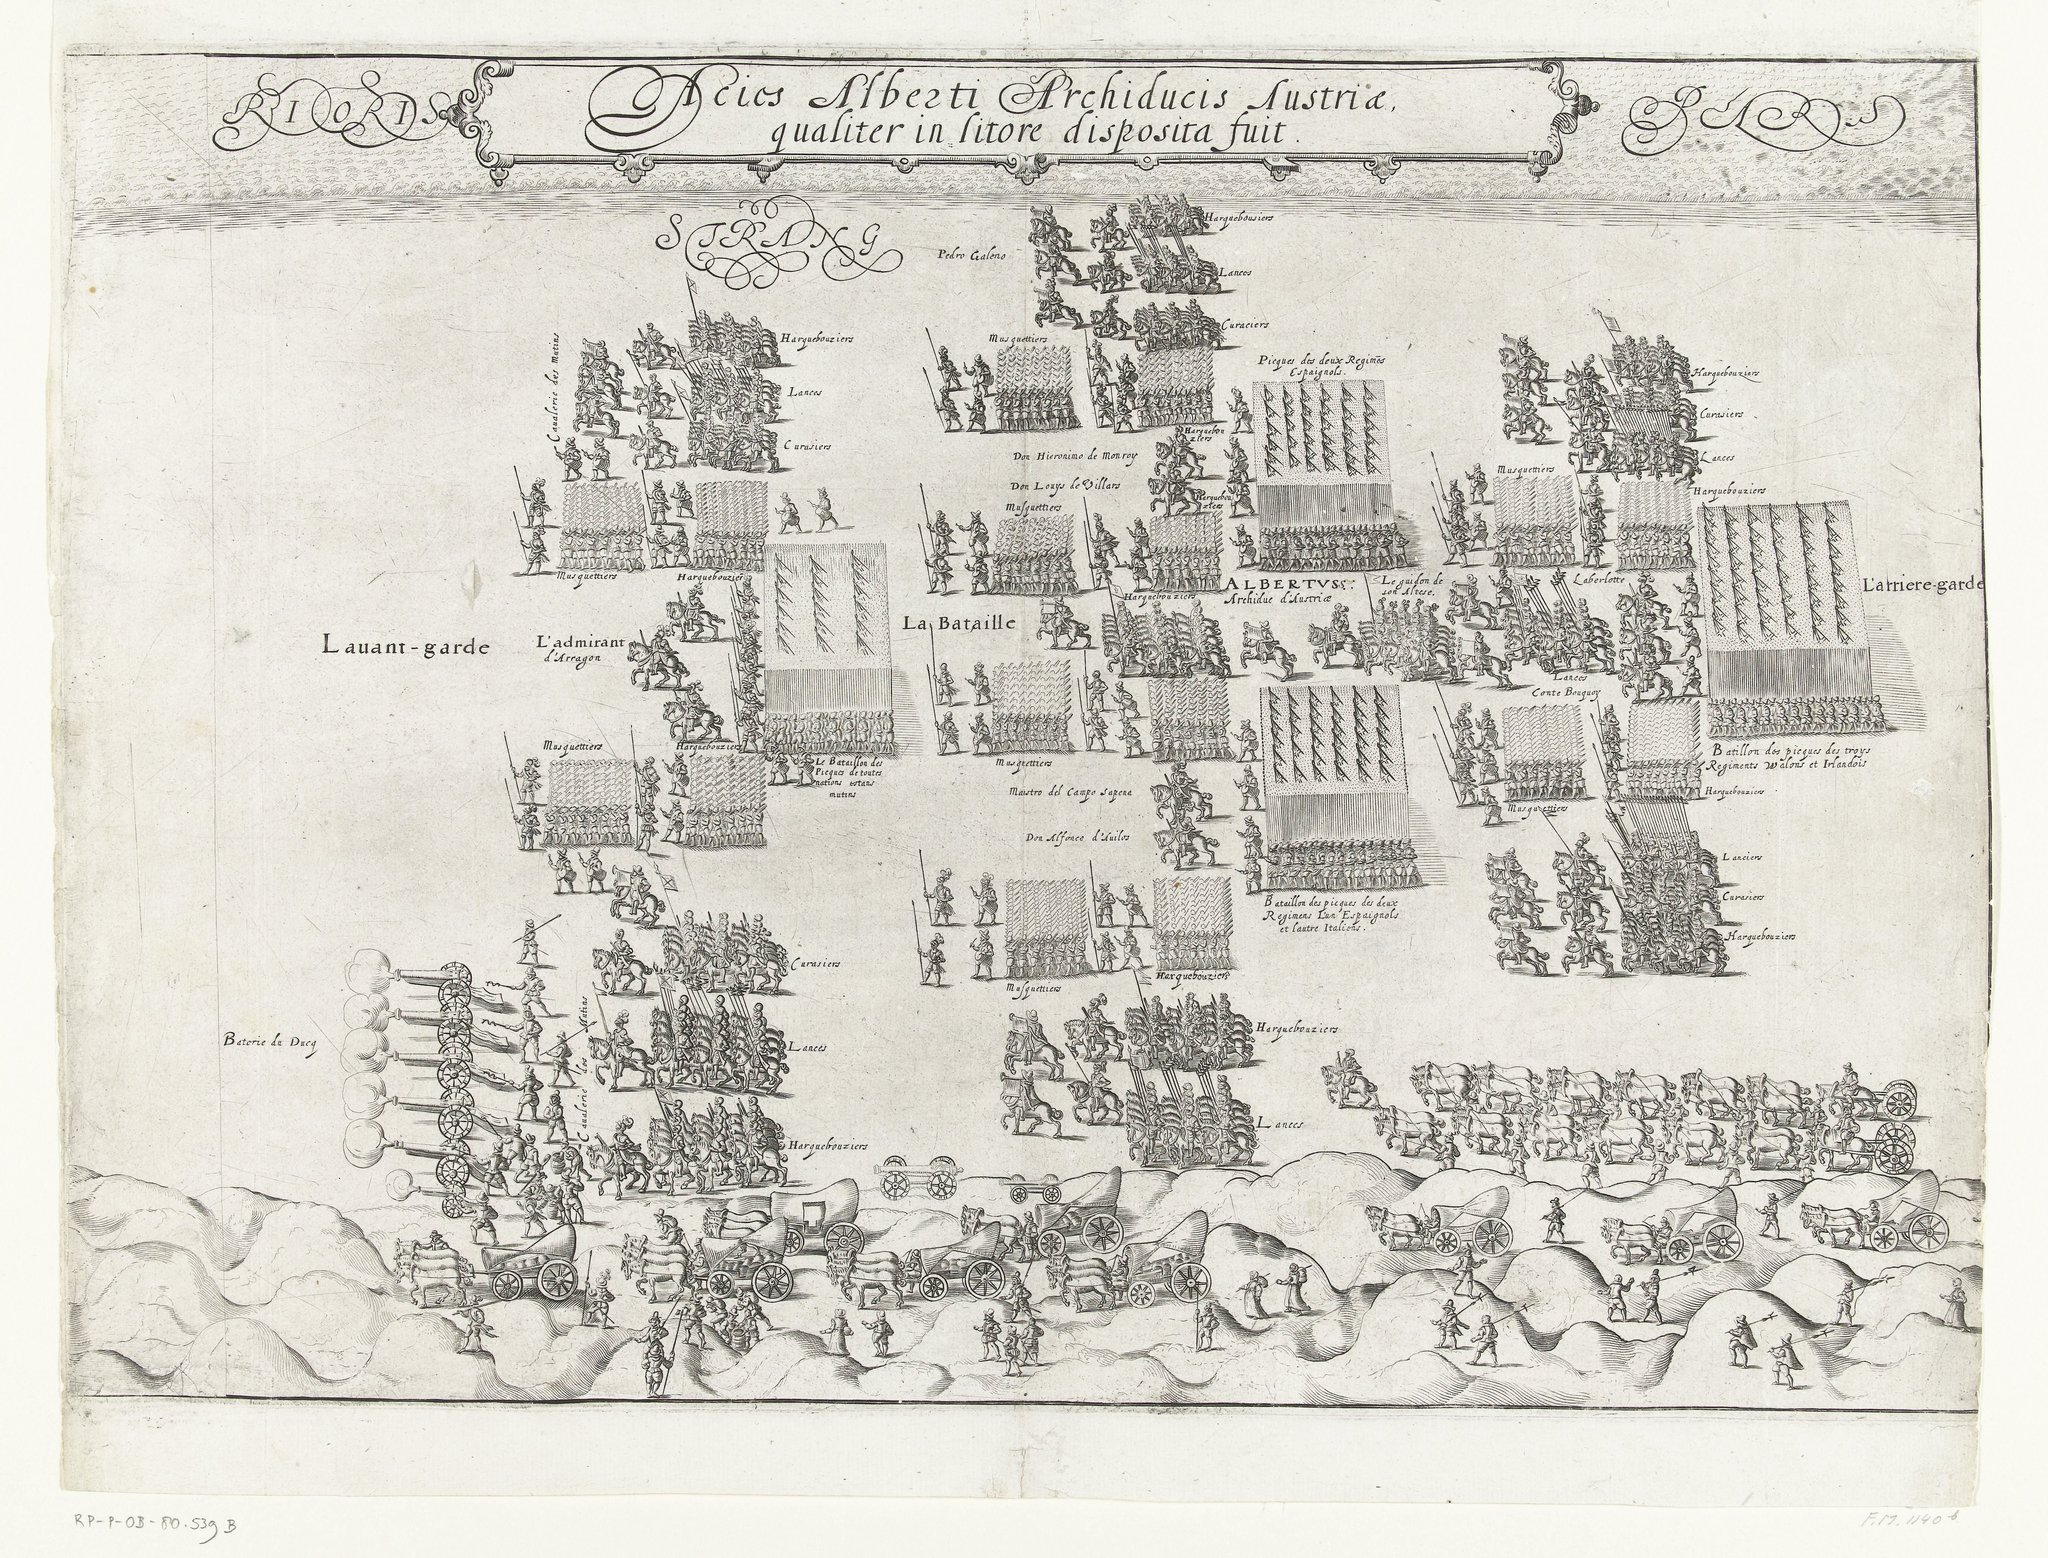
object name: print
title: De Staatse en Spaanse legers staan tegenover elkaar op het strand bij Nieuwpoort (rechterblad), 1600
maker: floris balthasarsz. van berckenrode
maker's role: print maker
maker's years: 1562-1616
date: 1600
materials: paper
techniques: engraving, etching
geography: northern netherlands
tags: brussels, albrecht aartshertog van oostenrijk, battle (+ land forces), battle of nieuwpoort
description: De Staatse en Spaanse legers staan tegenover elkaar op het strand bij Nieuwpoort, 2 juli 1600. De rechterplaat met de slagorde van het Spaanse leger onder Albrecht, naar links bewegend. In het midden de aartshertog Albrecht te paard. Bovenaan een cartouche met opschrift in het Latijn. Met opschriften en namen van regimenten en legeroversten in het Latijn.